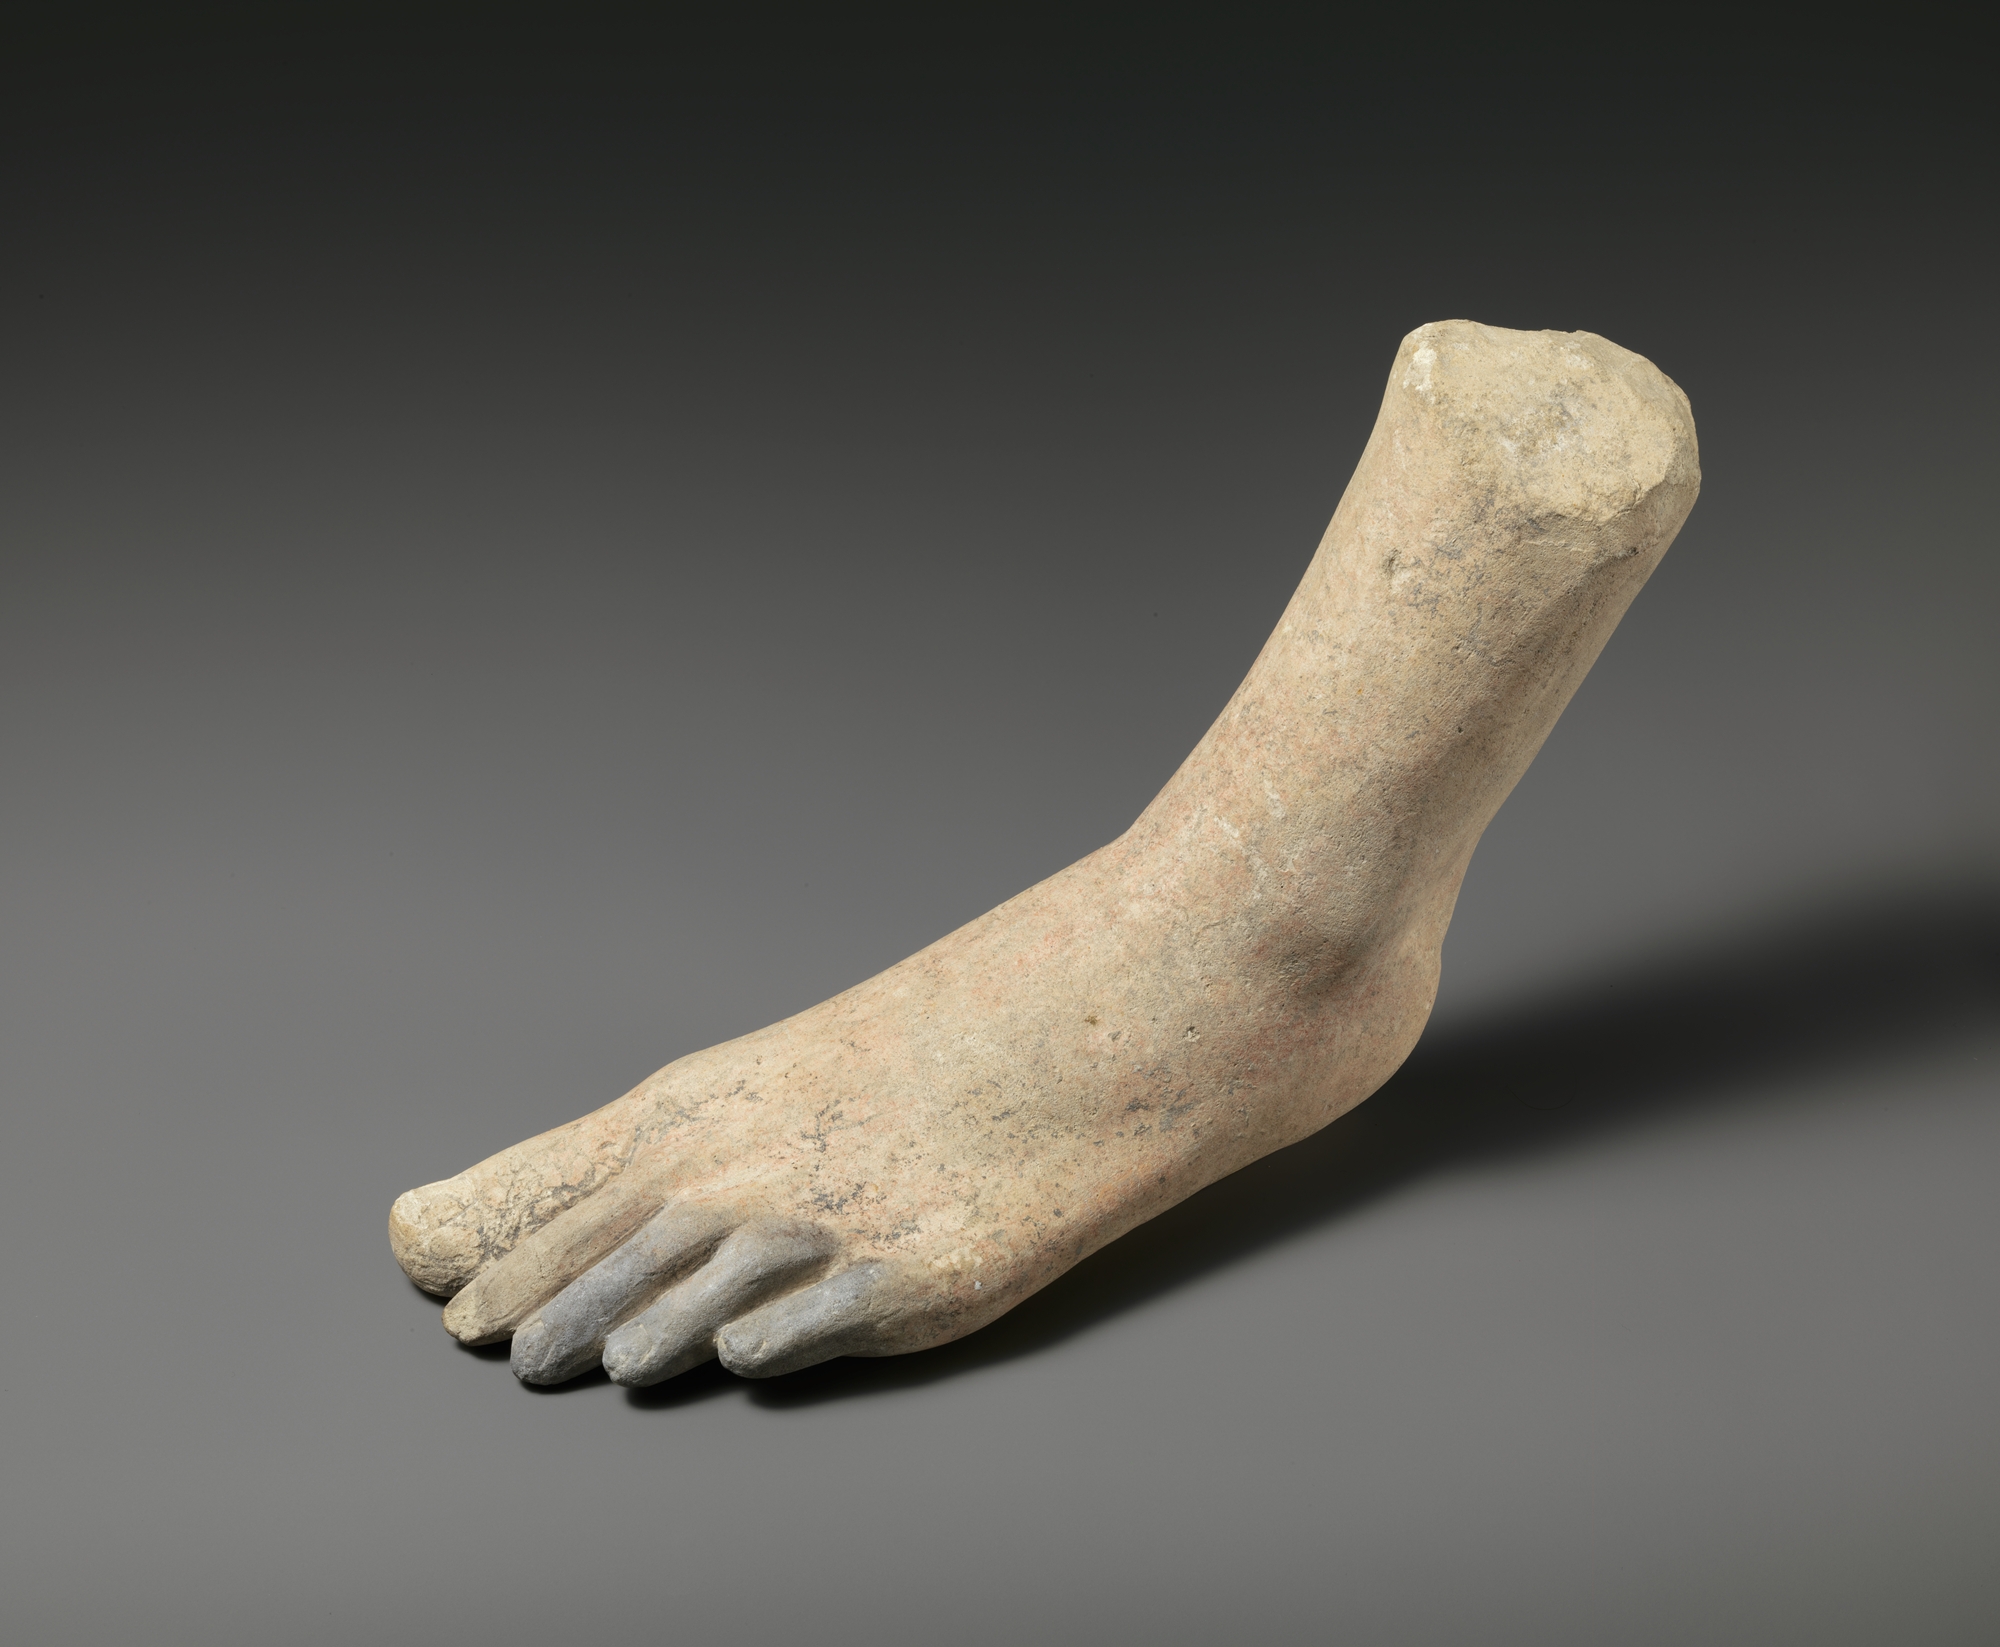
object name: foot, left, votive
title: Limestone lower left leg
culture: cypriot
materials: limestone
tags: feet